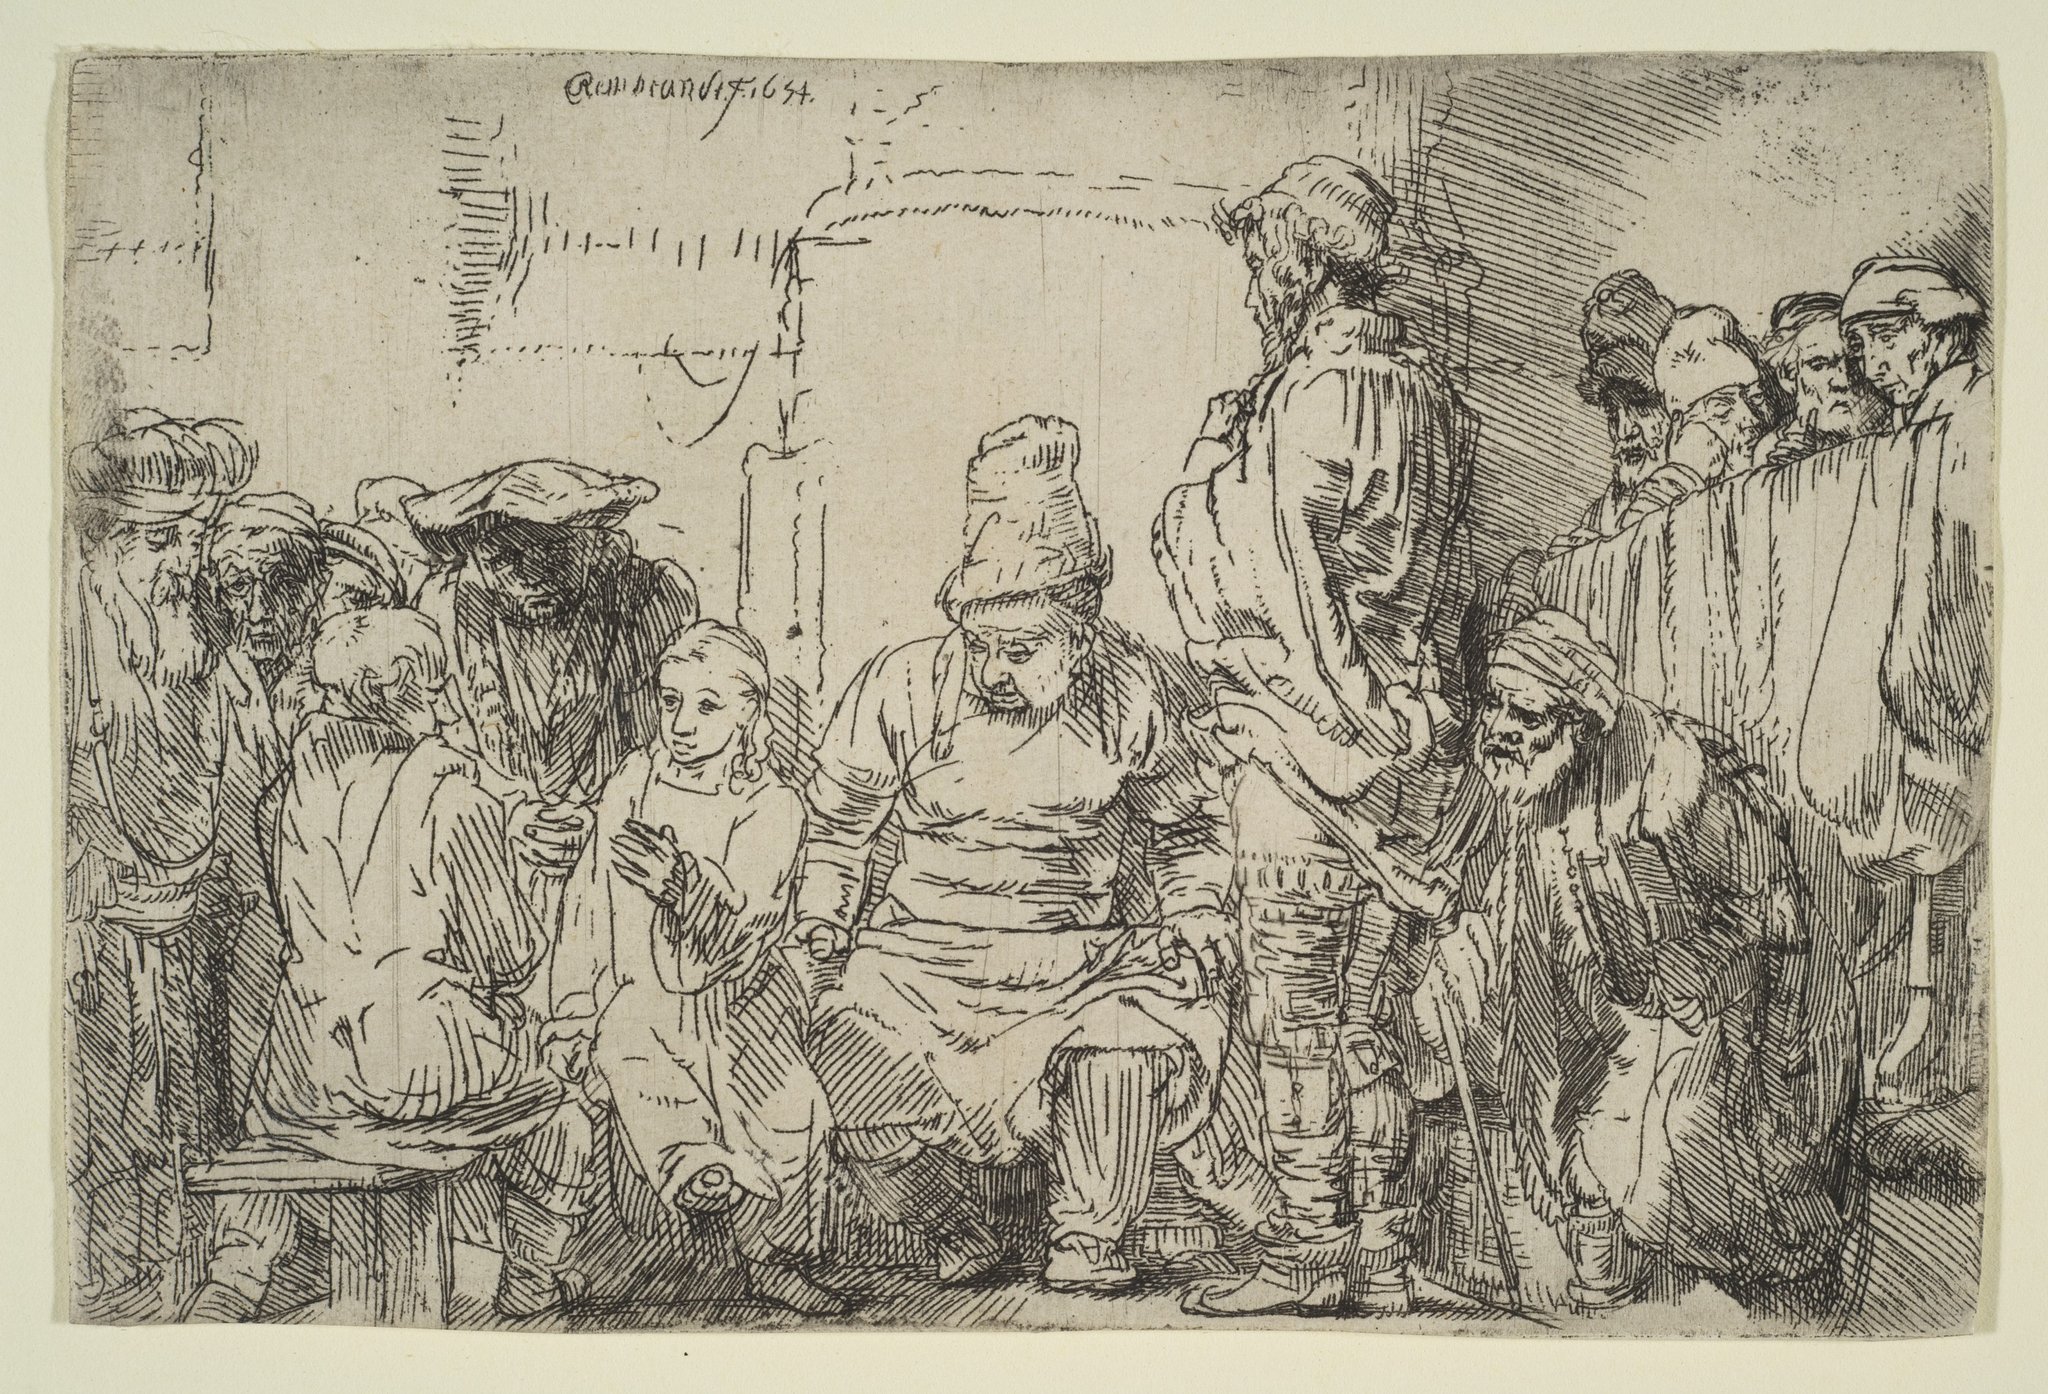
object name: print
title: Christ Seated Disputing with the Doctors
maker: rembrandt van rijn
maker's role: artist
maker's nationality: dutch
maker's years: 1606-1669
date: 1654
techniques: etching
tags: girls,men,christ,doctors